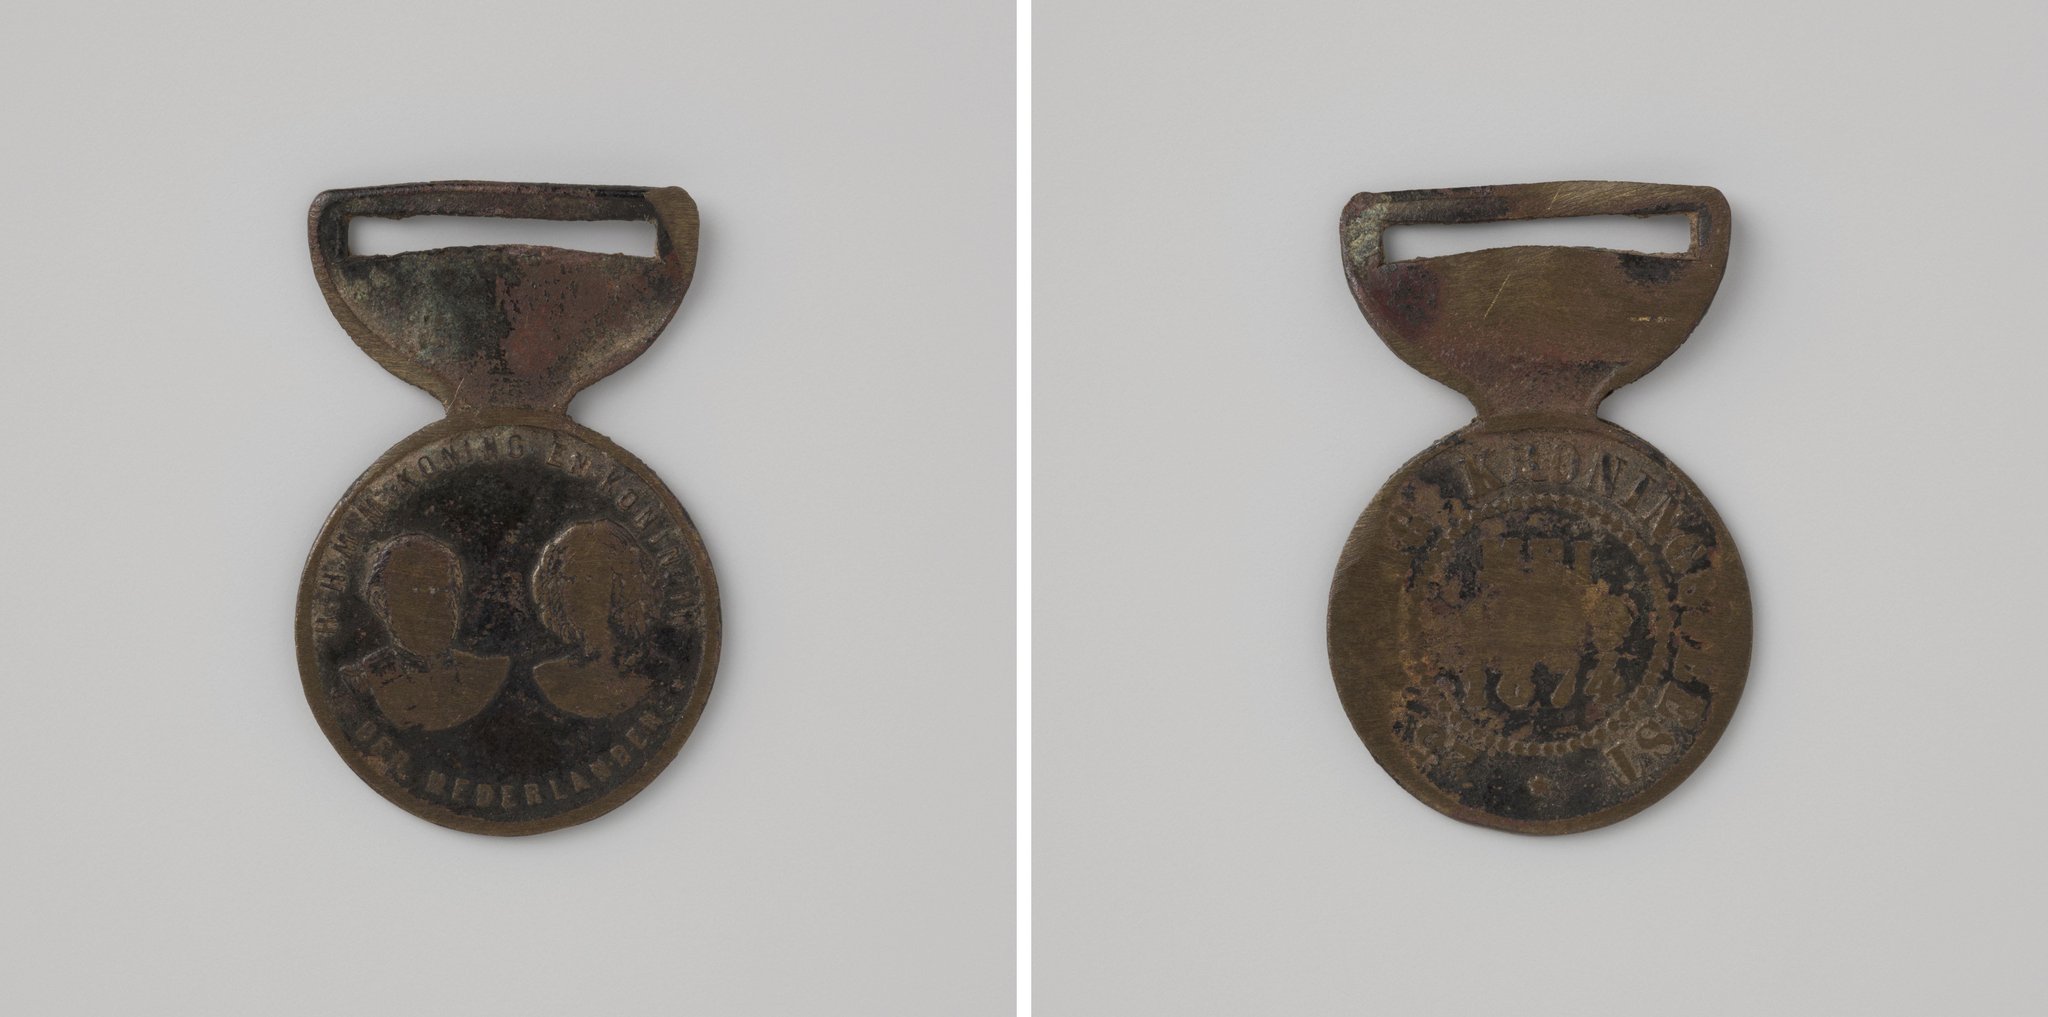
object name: history medal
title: Vijfentwintigjarig regeringsjubileuwm van koning Willem III en Koningin Sophia 1874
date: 1874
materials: brass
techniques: striking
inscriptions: circumscription: ‘H.H.M.M. KONING EN KONINGIN / DER NEDERLANDEN’, circumscription: ‘25 JARIG KRONINGSFEEST’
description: Draaggesp met medaillon van verzilverd messing, op de voorzijde de aanziende portretten van Willem III en Sophia met omschrift, op de keerzijde drie regels tekst met omschrift.